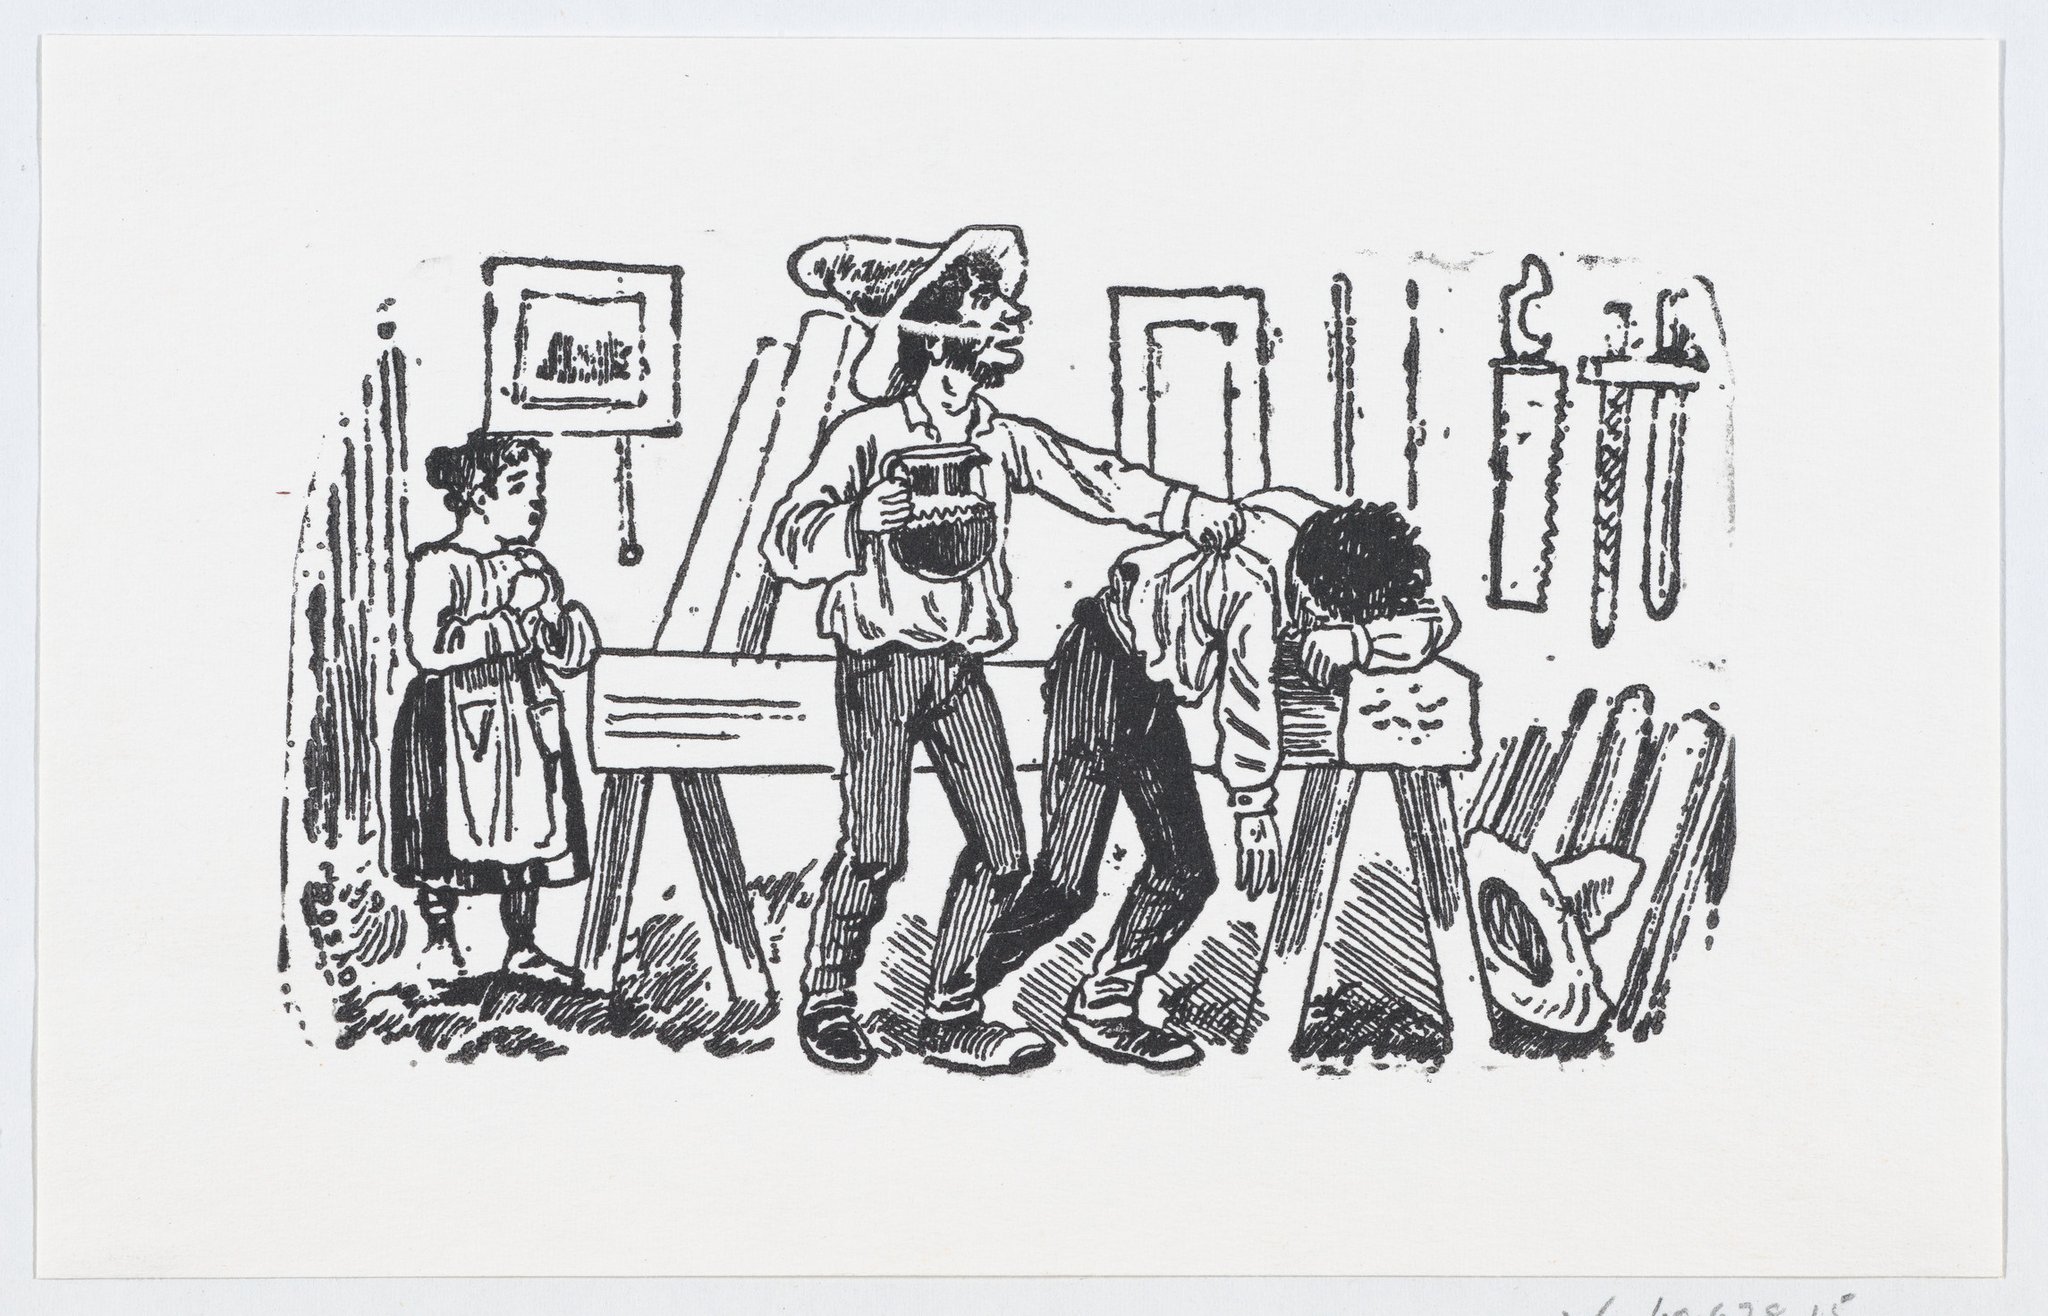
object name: print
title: A man with a pitcher in his hand tapping the shoulder of another man resting on wooden beam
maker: josé guadalupe posada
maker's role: artist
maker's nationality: mexican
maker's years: 1852-1913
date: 1880-1910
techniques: lithography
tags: men,women,pitchers